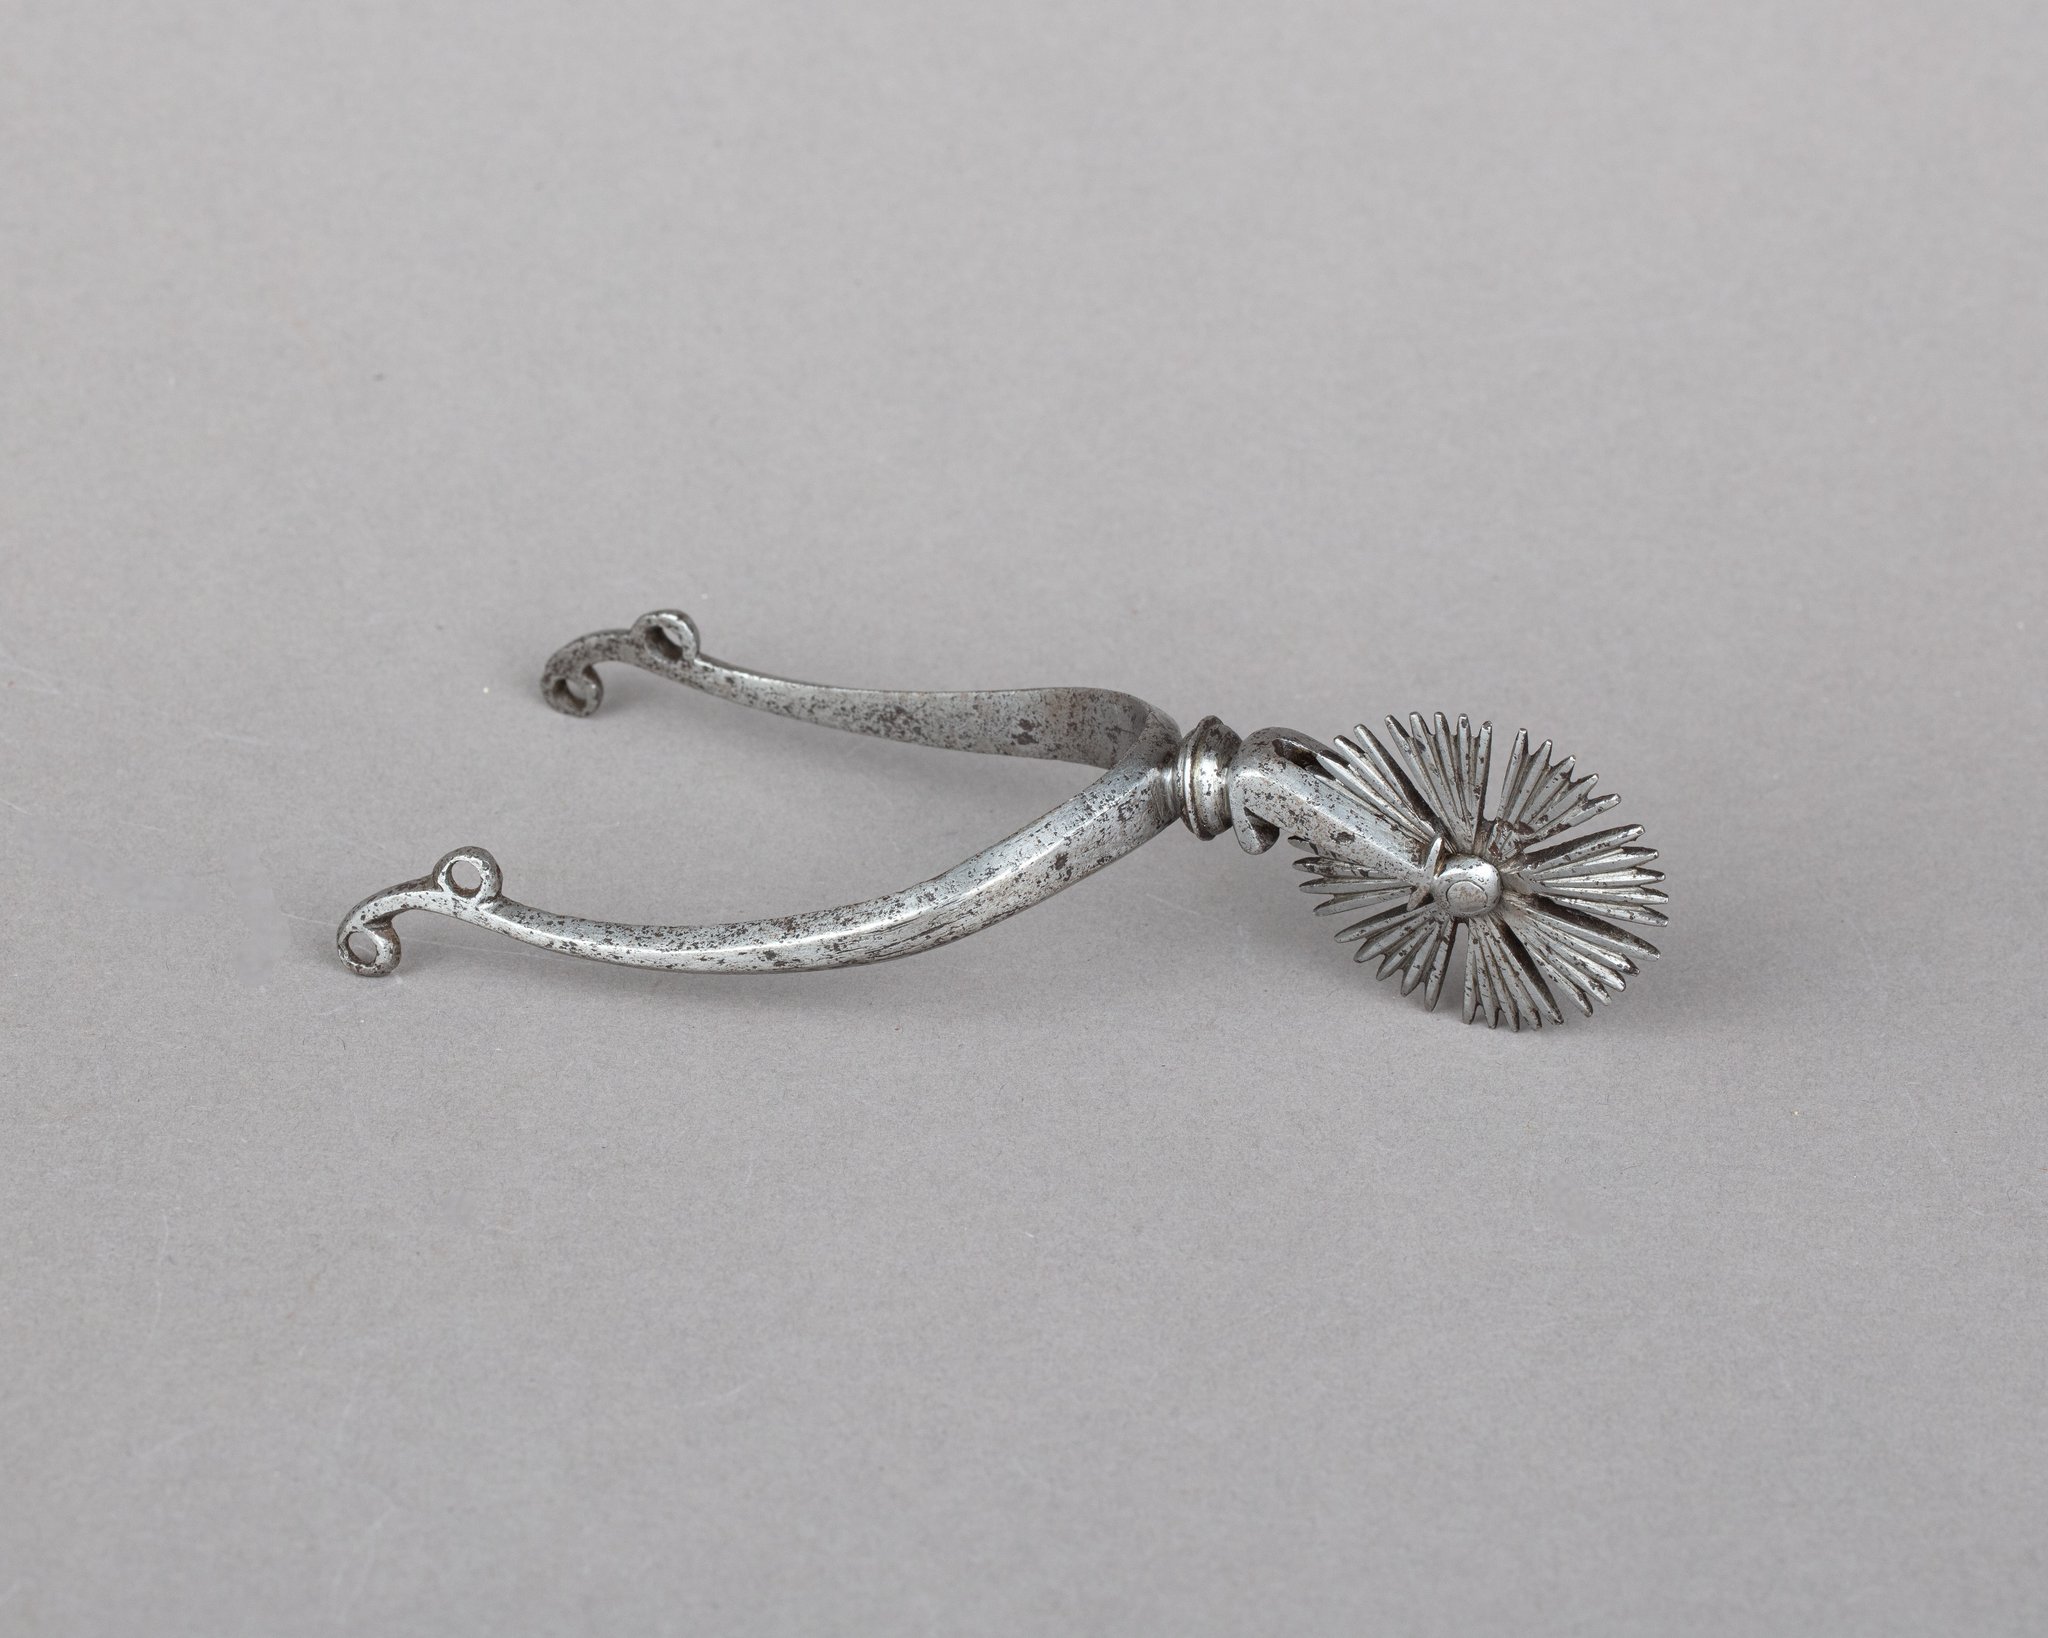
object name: spur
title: Rowel Spur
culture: italian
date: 1567-1700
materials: metal alloy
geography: italy